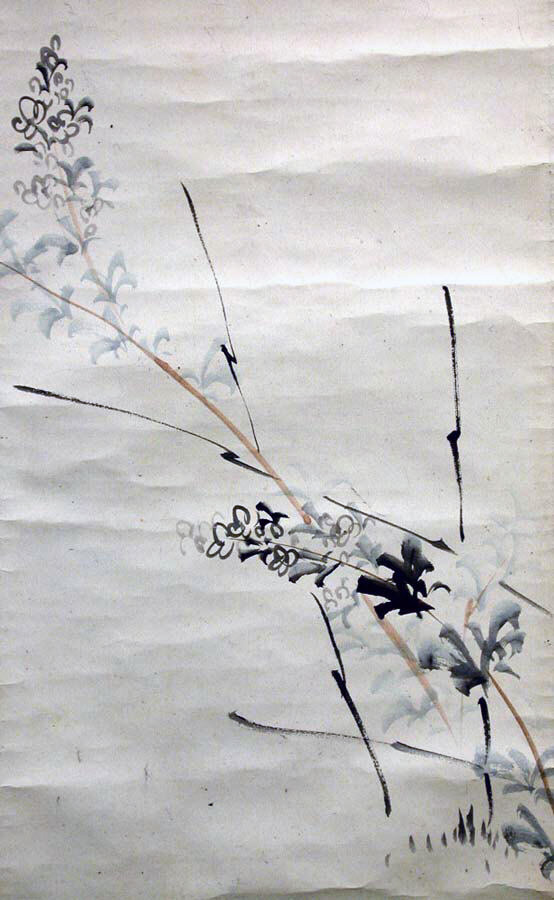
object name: hanging scroll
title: Deutzia Crenata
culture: japanese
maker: ōtagaki rengetsu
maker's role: artist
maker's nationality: japanese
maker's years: 1791-1875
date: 1791-1871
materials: ink, paper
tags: flowers